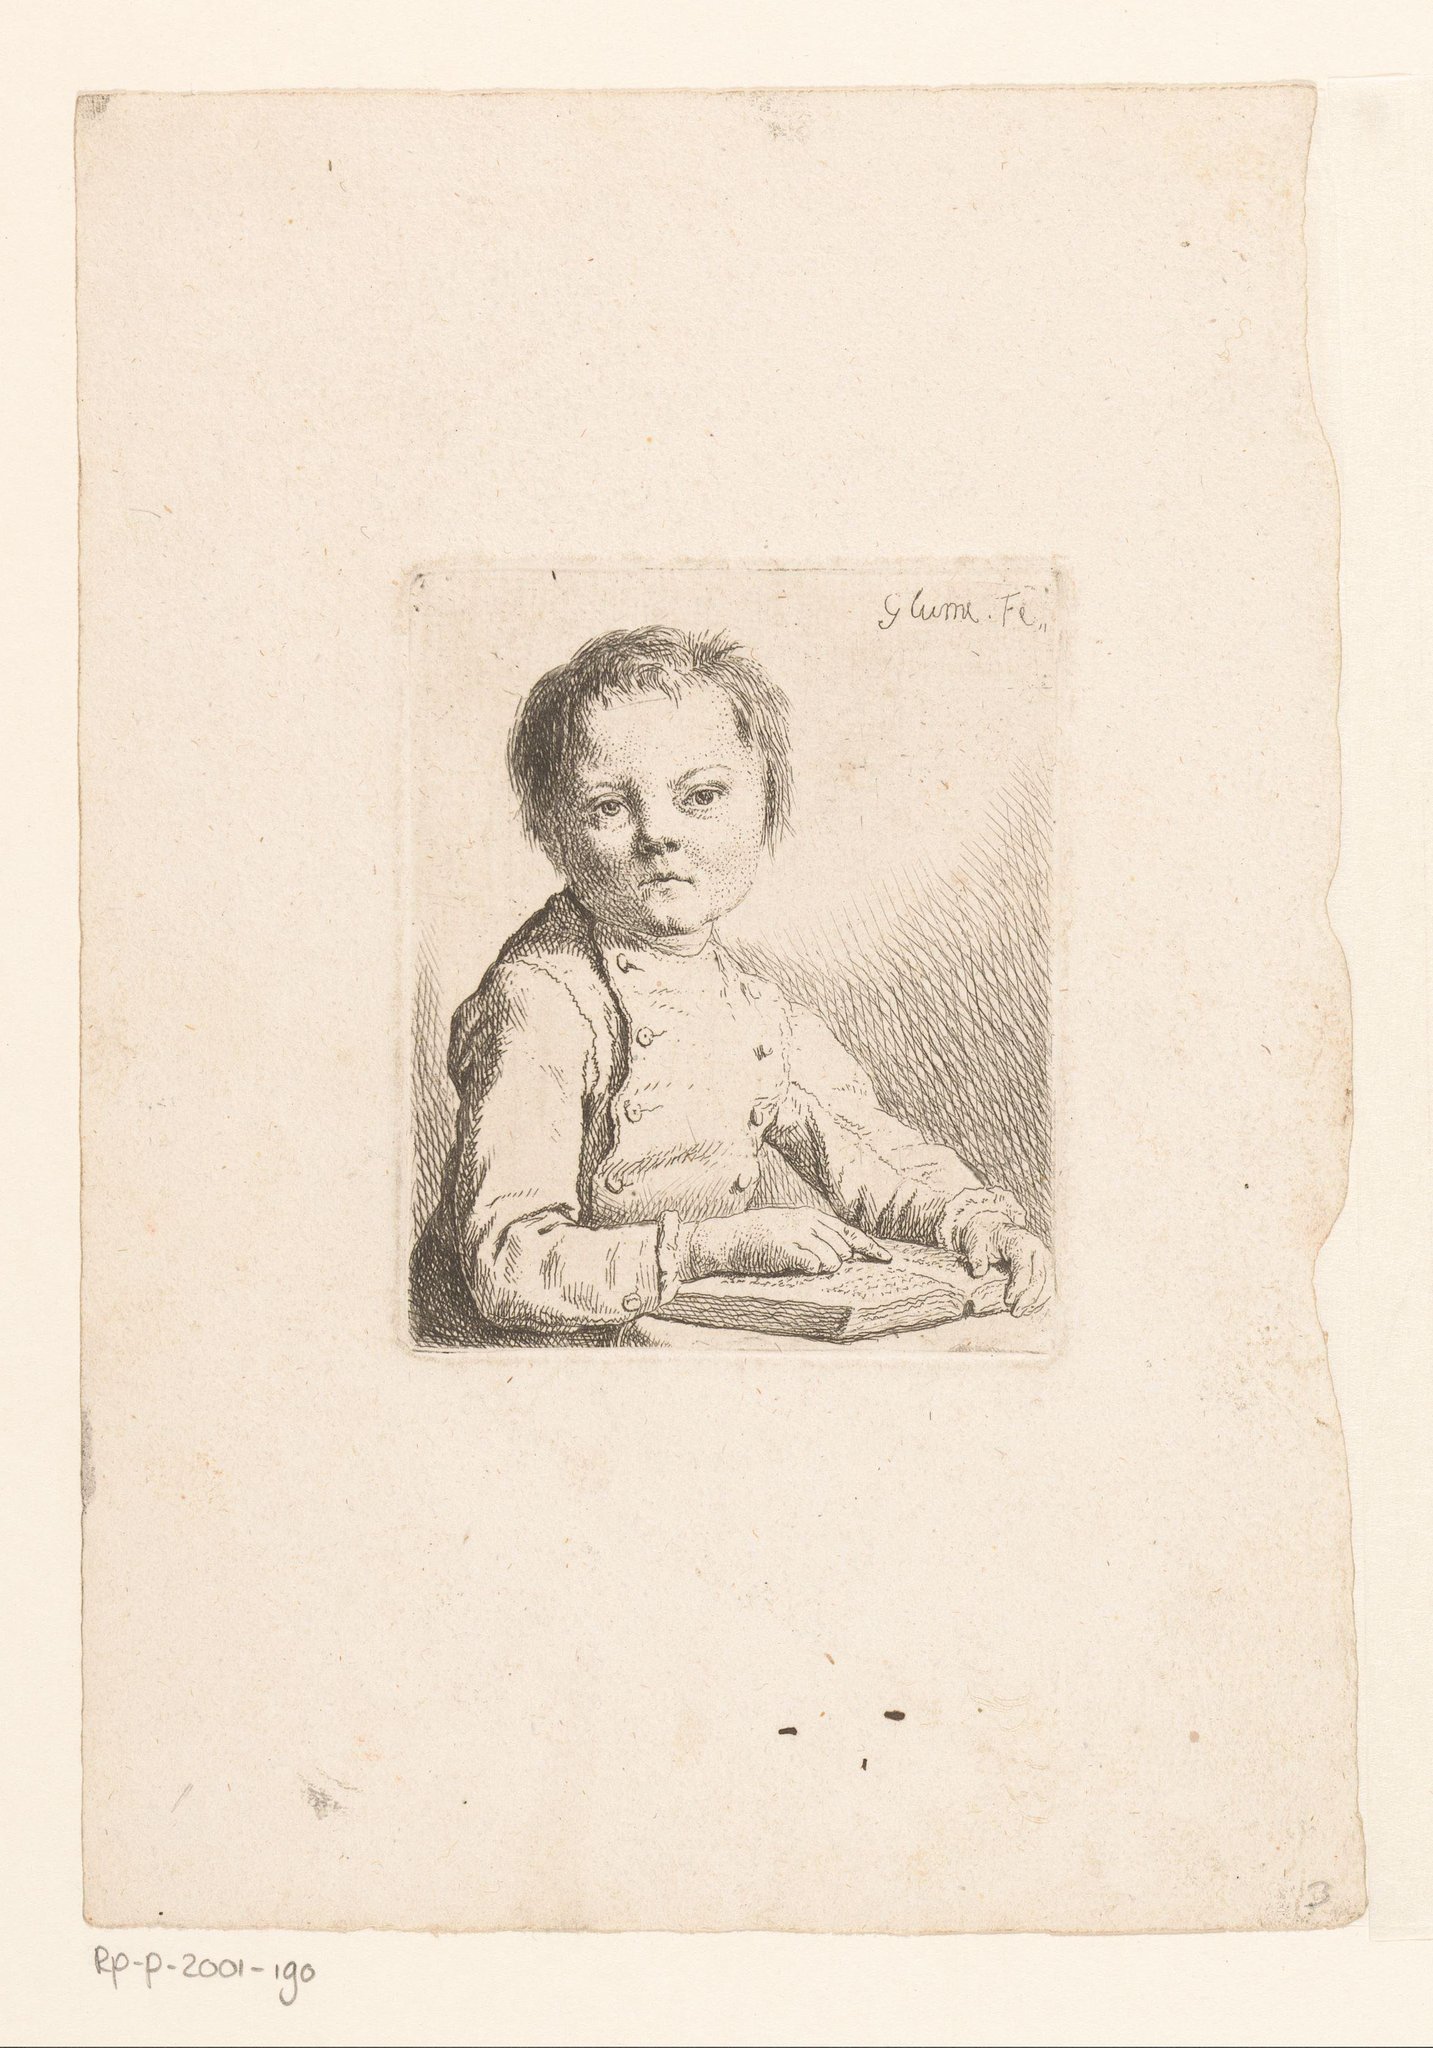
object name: print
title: Lezende jongen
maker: johann gottlieb glume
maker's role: print maker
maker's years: 1711-1778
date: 1721-1778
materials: paper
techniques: etching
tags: reading, boy (child between toddler and youth)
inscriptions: collector's mark: ‘S ch K’, collector's mark: Lugt 3870